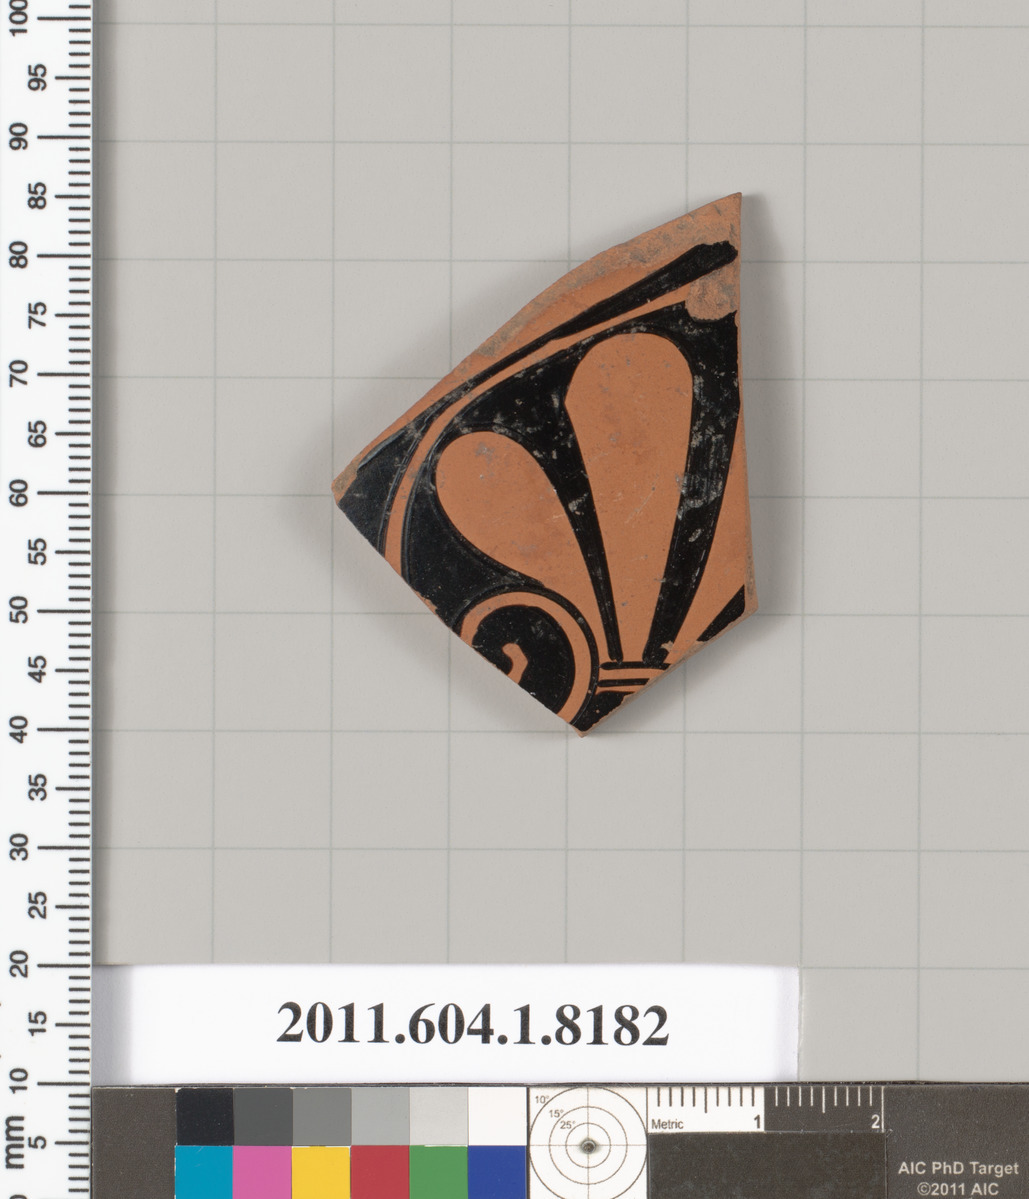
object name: kylix fragment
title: Terracotta fragment of a kylix (drinking cup)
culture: greek, attic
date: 520-510 BCE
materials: terracotta